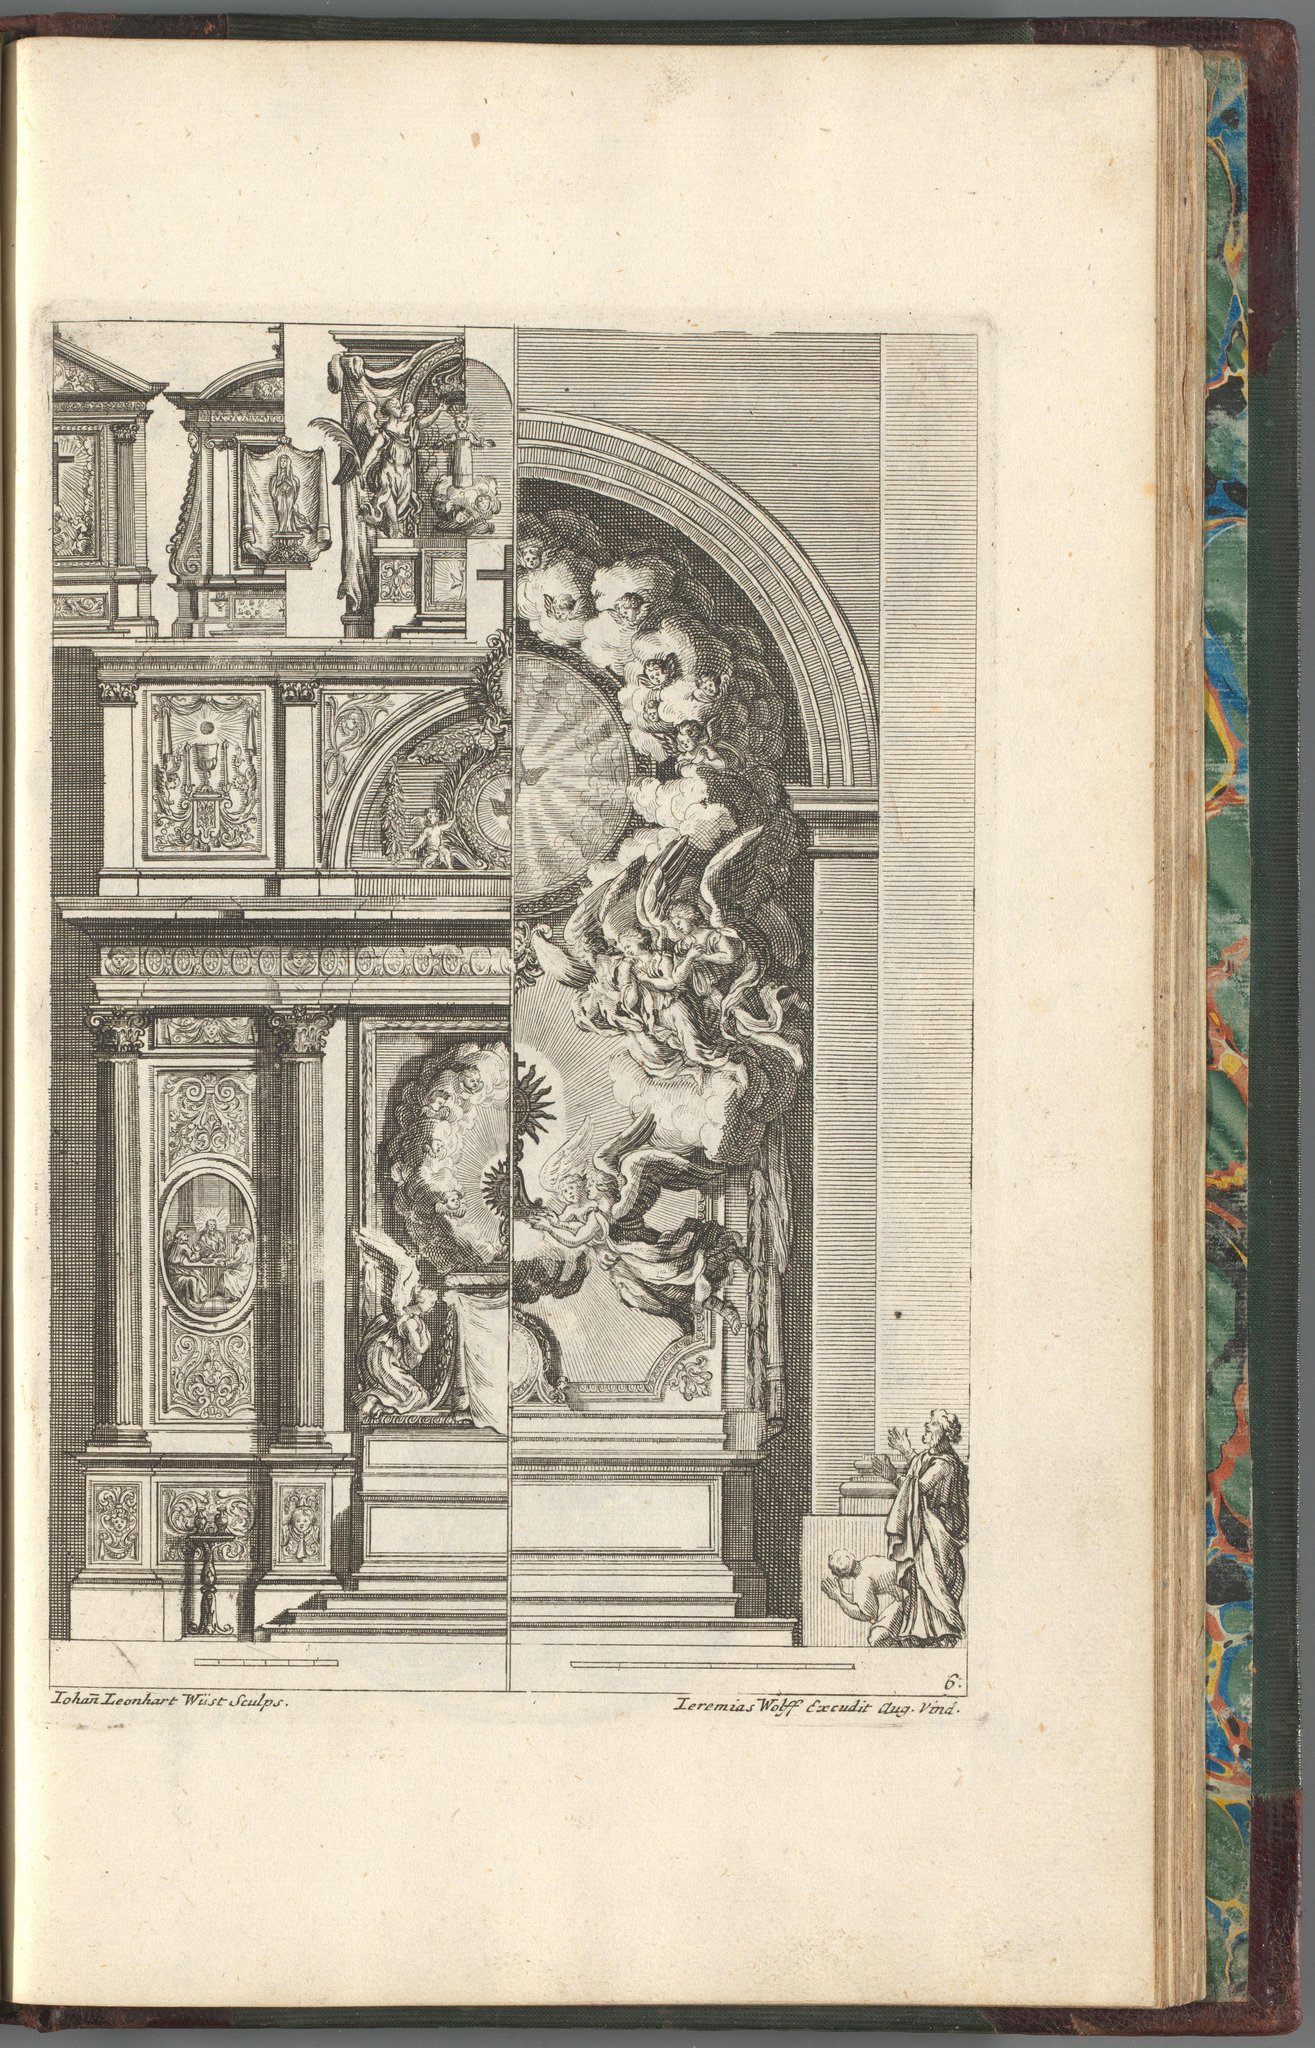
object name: album leaf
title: Ontwerpen van altaren met engelen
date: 1686-1724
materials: paper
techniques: engraving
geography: augsburg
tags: ornaments ~ art, altar, angels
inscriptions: signature: ‘Ieremias Wolff Excudit Aug. Vind.’, number: ‘6.’, signature: ‘Iohan Leonhart Wüst Sculps.’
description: Een gravure met twee ontwerpen voor altaarversiering met engelen. Prent maakt deel uit van een album.